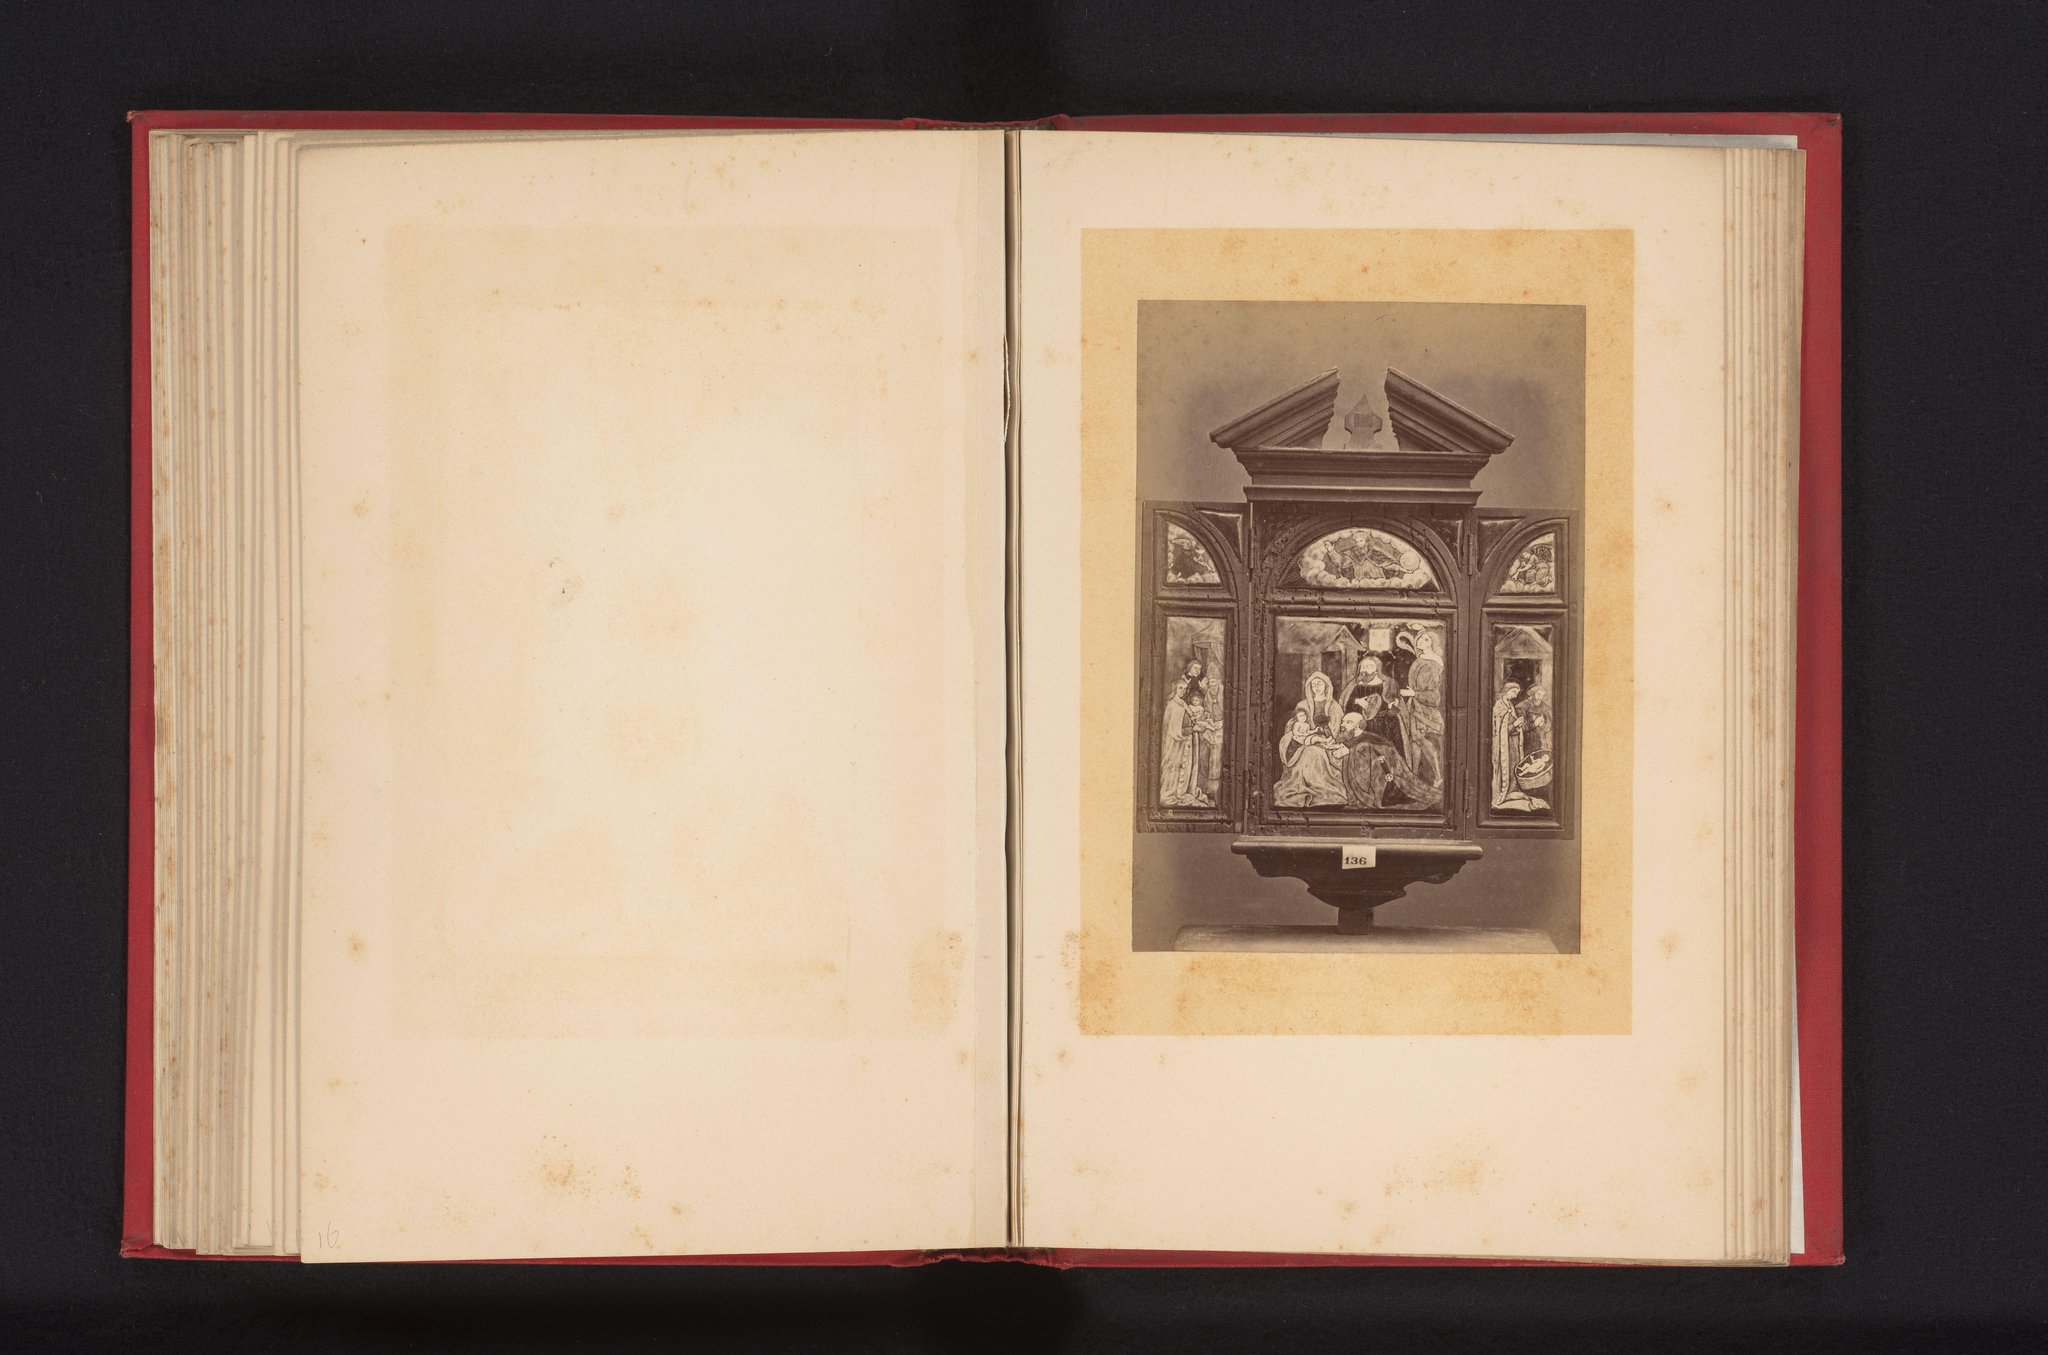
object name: photograph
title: Drieluik van email met afgebeeld de geboorte van Christus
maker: Anonymous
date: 1872-1878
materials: photographic support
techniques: albumen print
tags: birth and youth of christ